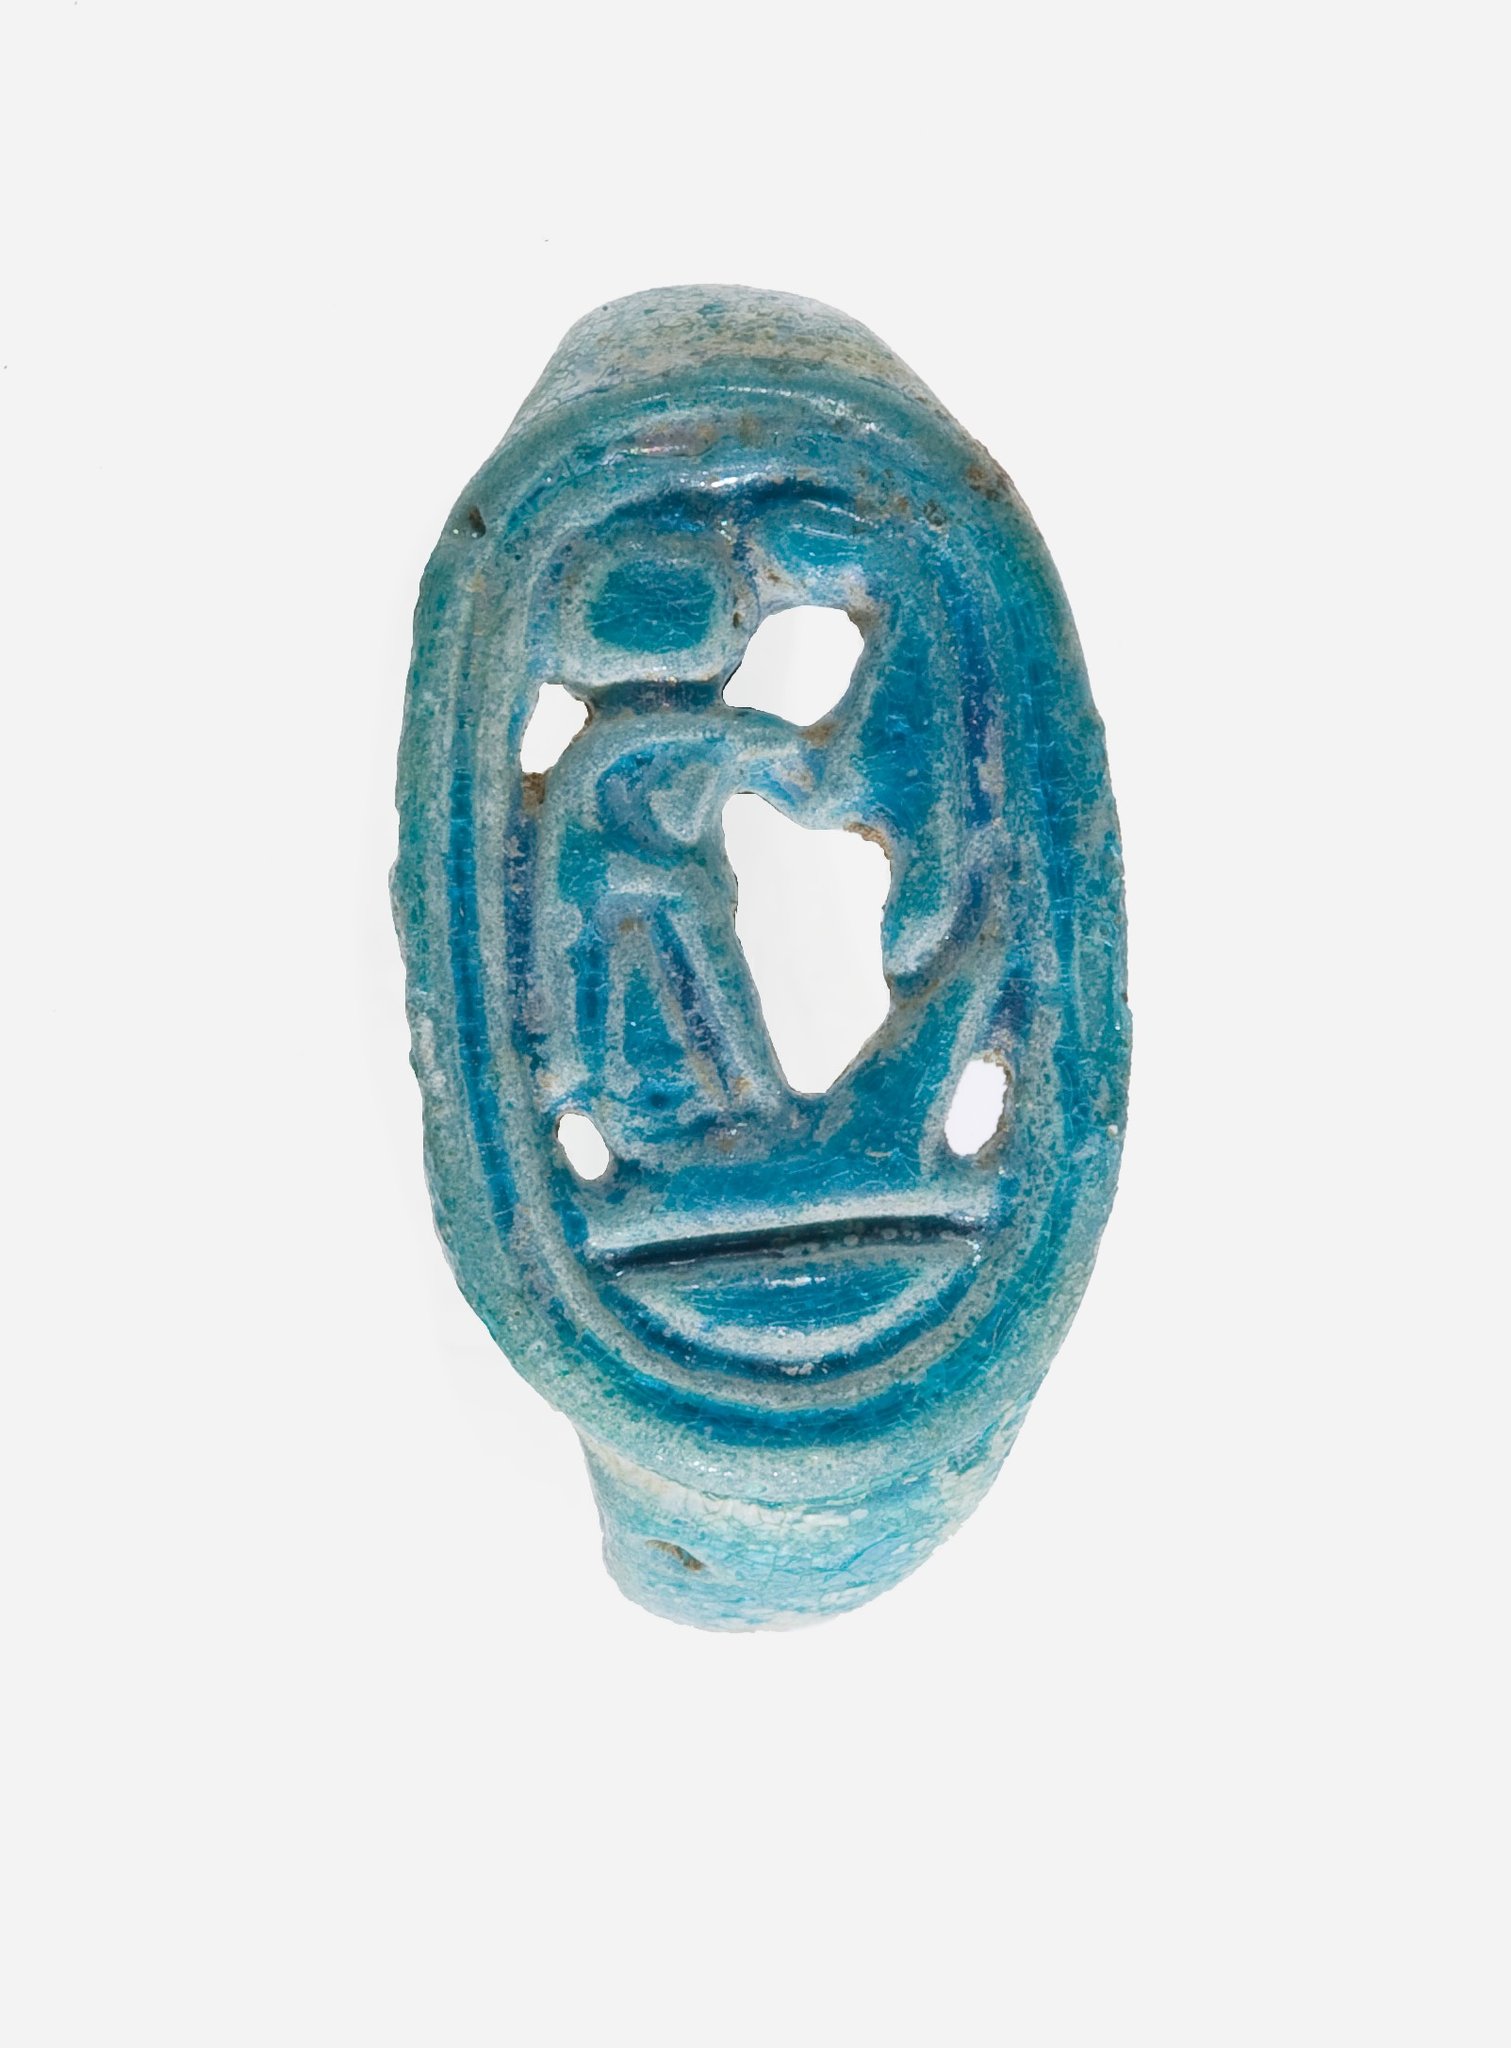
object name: ring, amenhotep iii prenomen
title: Pierced Ring, Prenomen of Amenhotep III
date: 1390-1352 BCE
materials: faience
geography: egypt